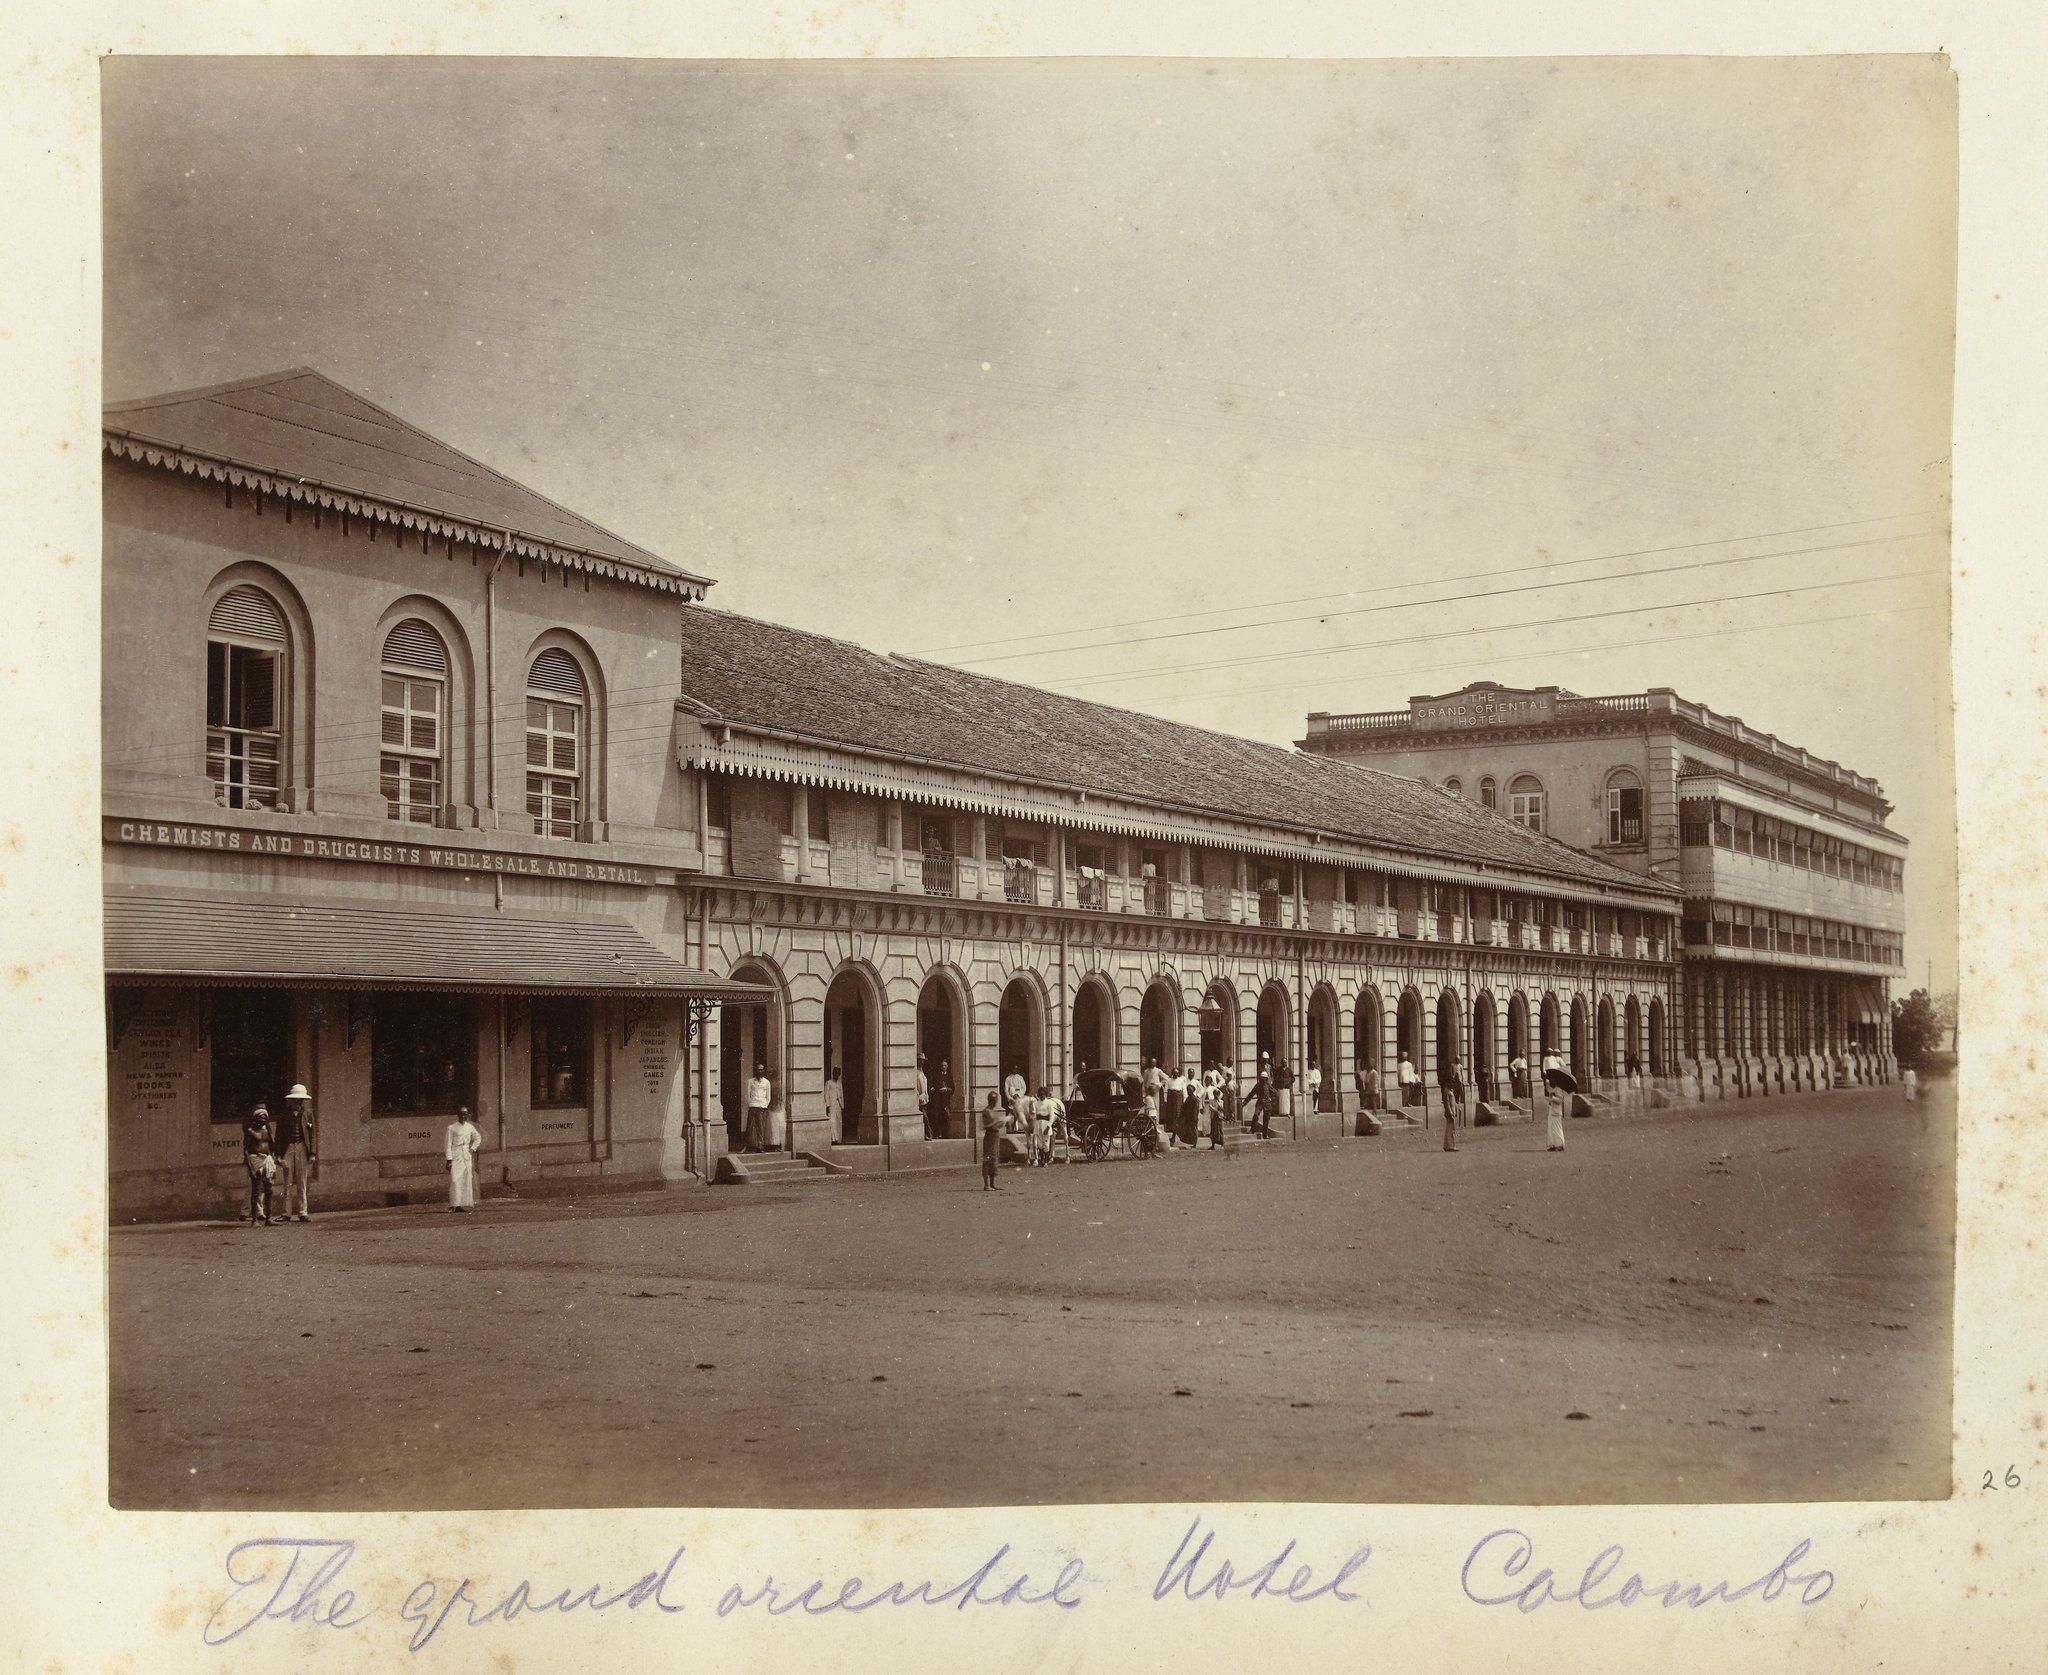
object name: photograph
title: The Grand Oriental Hotel Colombo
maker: Anonymous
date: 1890-1910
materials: cardboard, paper, photographic support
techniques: gelatin silver print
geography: netherlands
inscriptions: caption: ‘The Grand Oriental Hotel Colombo’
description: Op straat poseert een aantal mensen voor de camera.